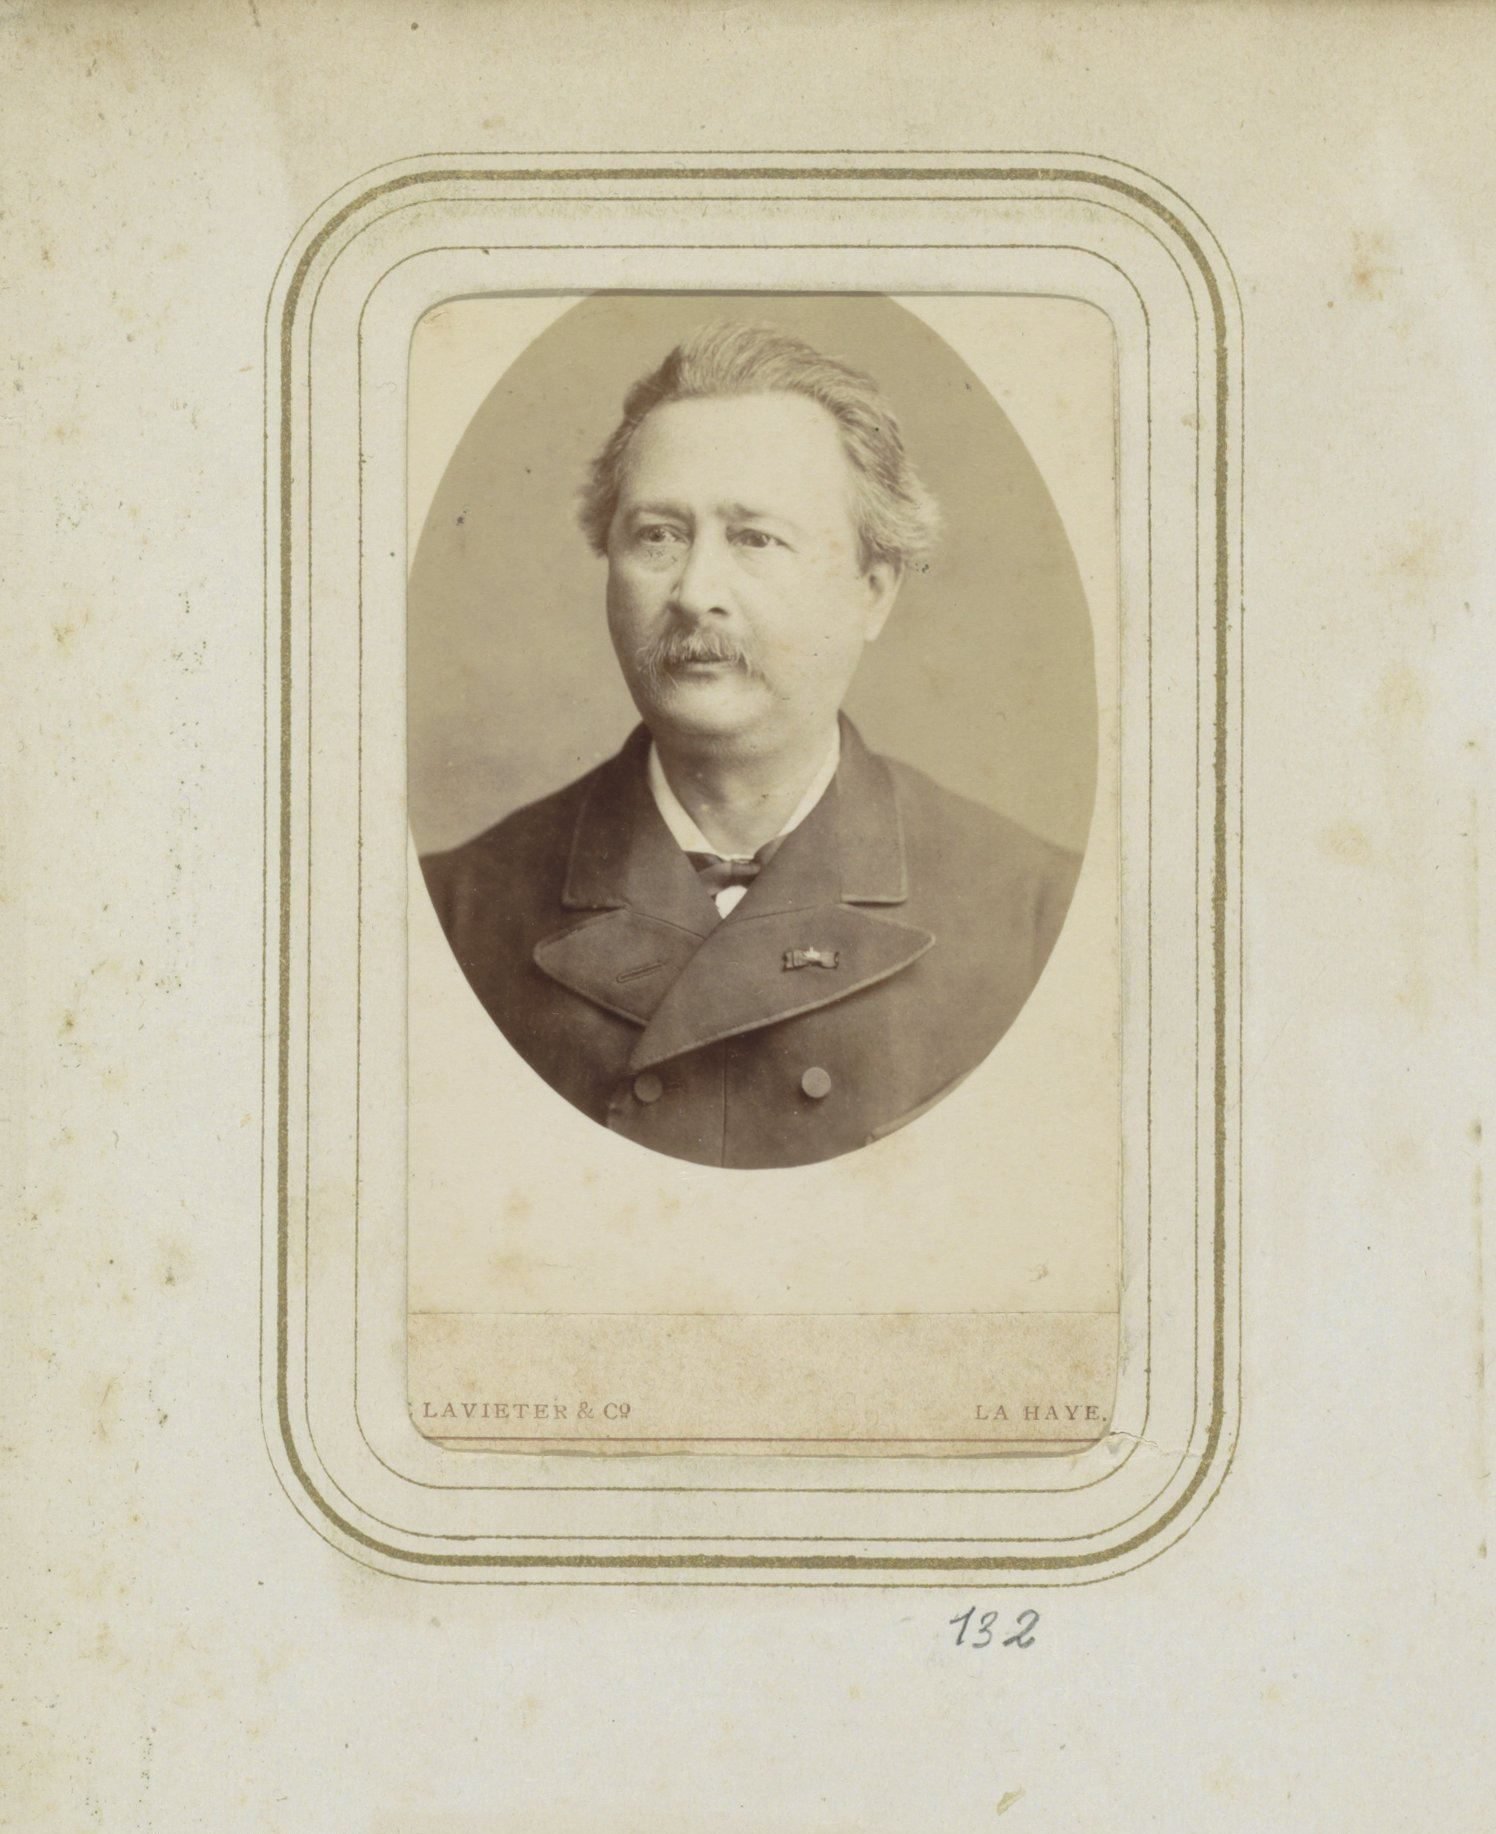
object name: carte de visite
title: Portret van een man met een snor in een jas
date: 1865-1903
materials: cardboard, photographic support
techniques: albumen print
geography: the hague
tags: moustache, historical persons, neck-gear ~ clothing, clothing for the upper part of the body, family, relationship, descent, hairdress, decorations, honours (as symbols of the state, etc.), the hague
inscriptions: address: ‘2. Willemstraat. La Haye.’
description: Onderdeel van Familiealbum van H.W.F. Ligtenberg en L.M. Swart met 149 foto's en cartes-de-visite.